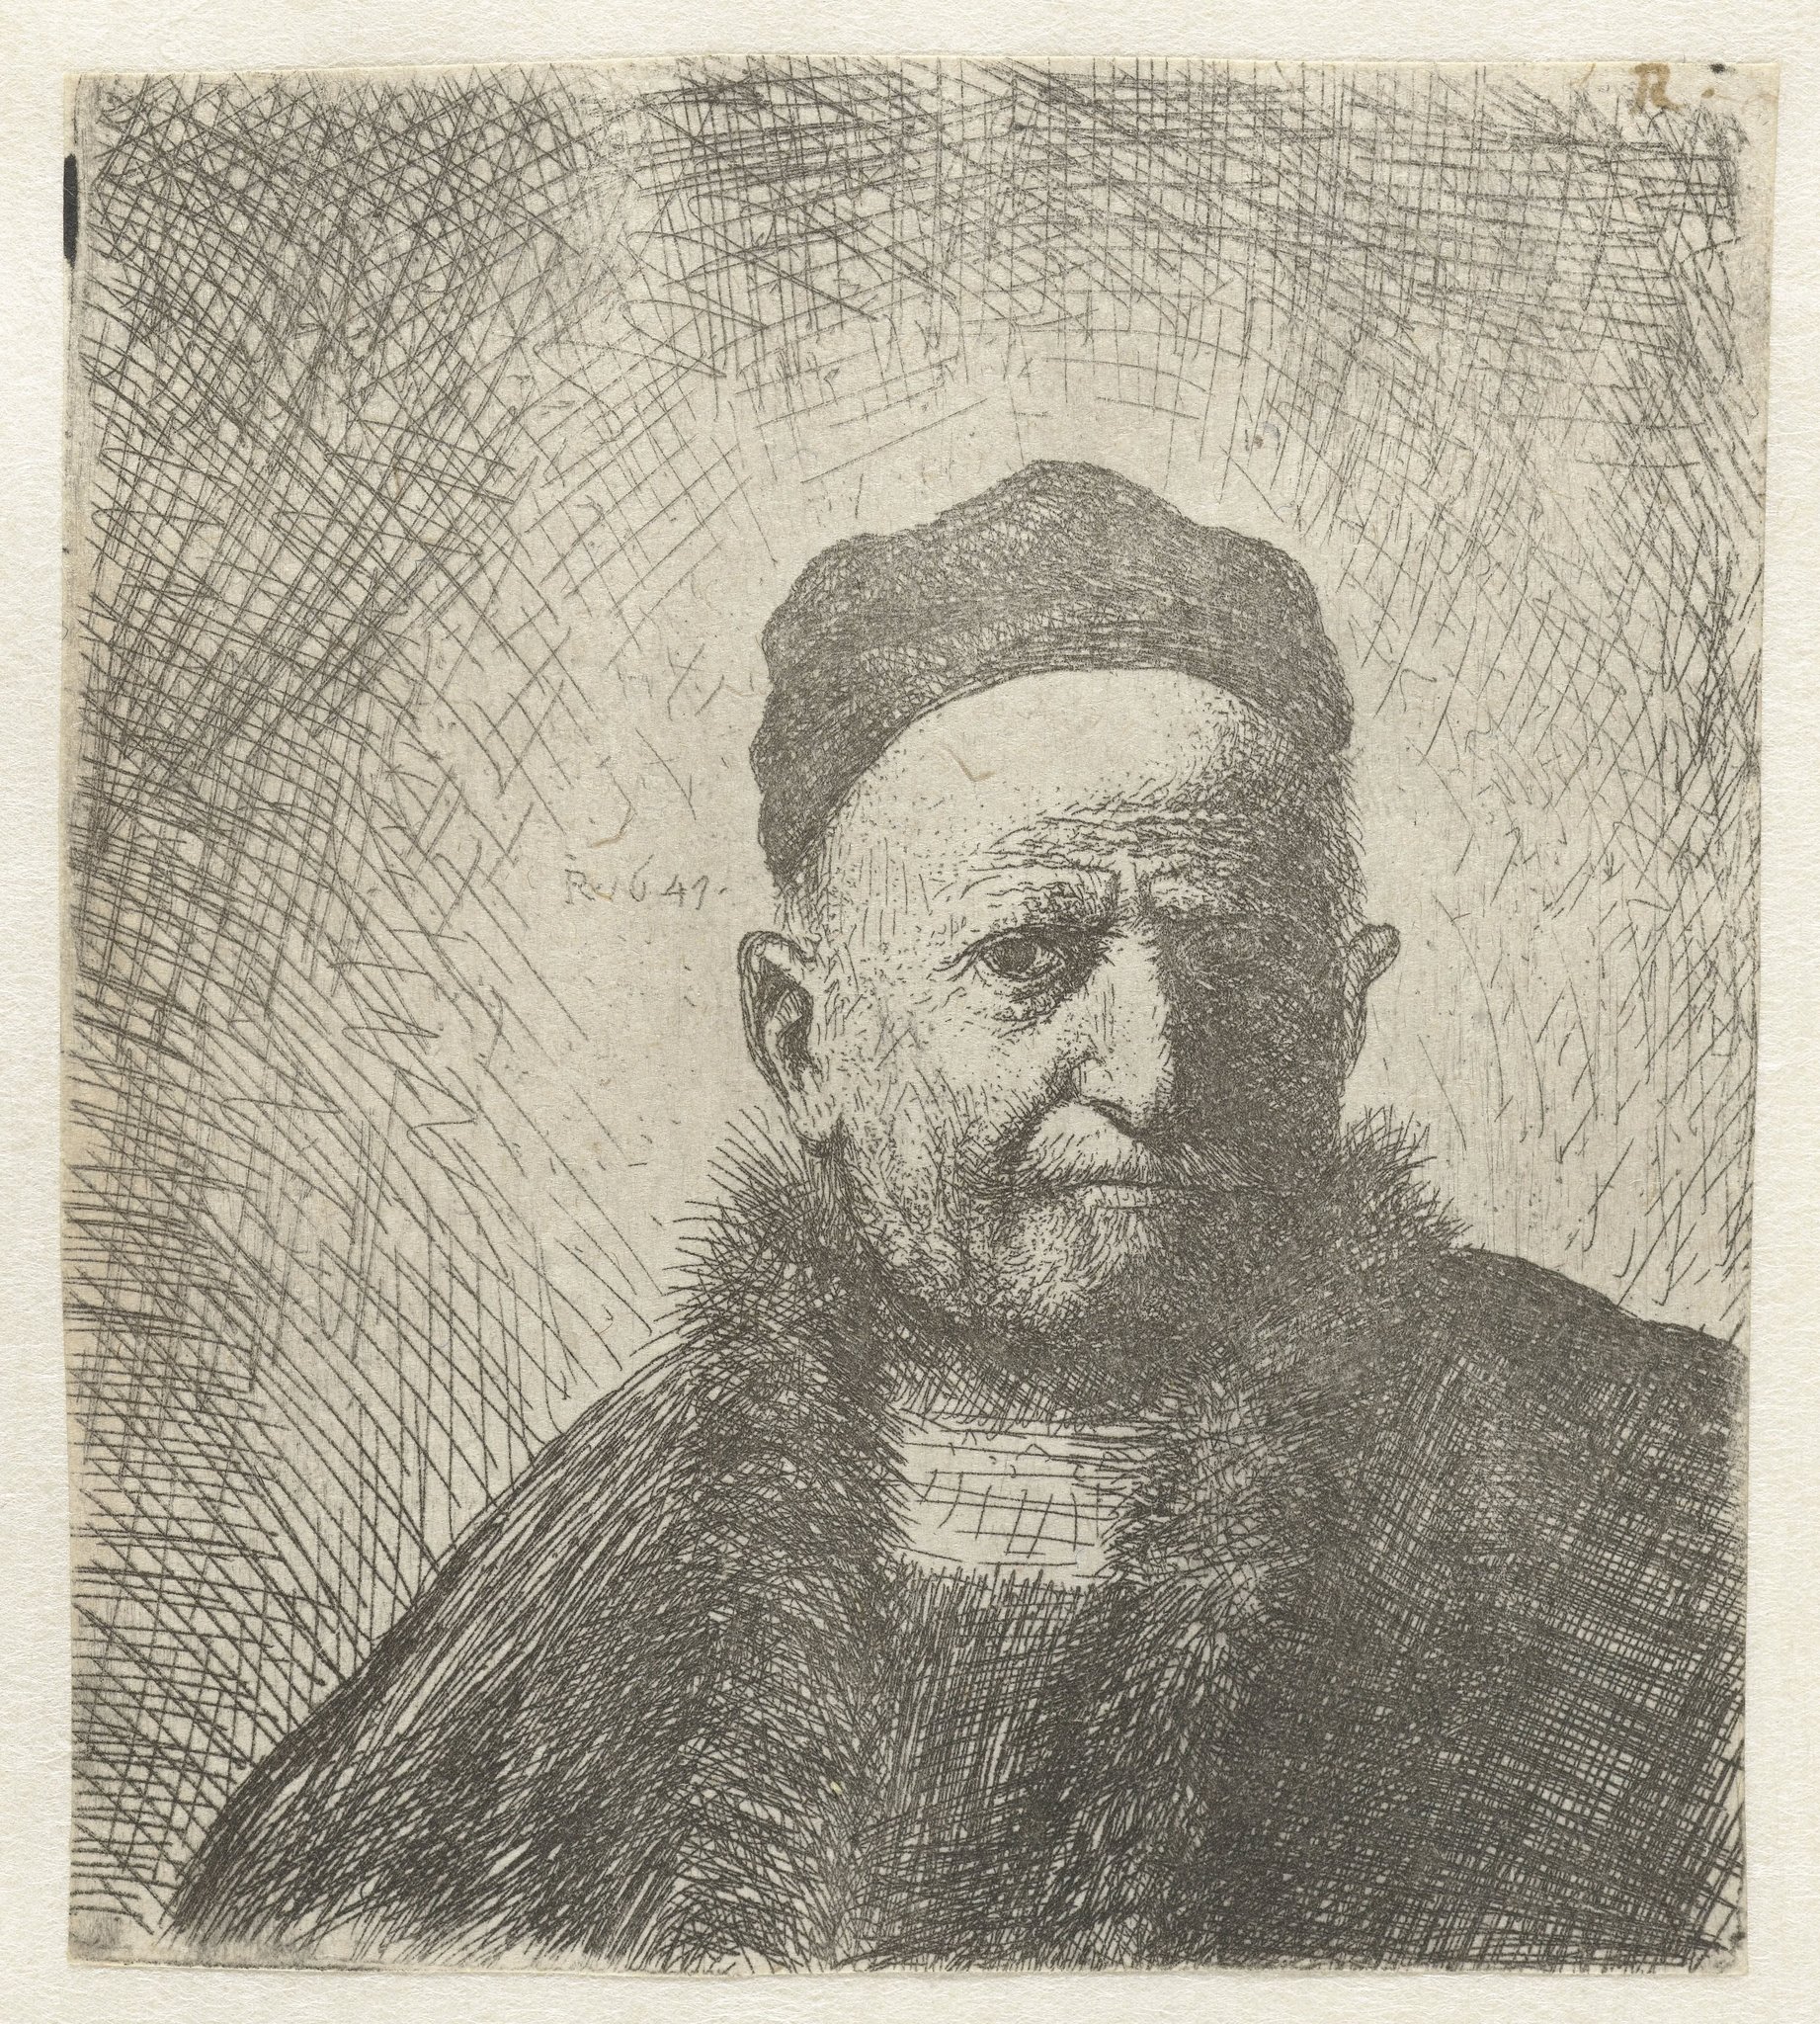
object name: print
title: Man wearing a close cap: bust (the artist’s father?)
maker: Anonymous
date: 1647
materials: paper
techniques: etching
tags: leiden, can hook, old man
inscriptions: collector's mark: Lugt 2166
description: Spiegelbeeldige kopie naar de gelijknamige prent van Rembrandt.